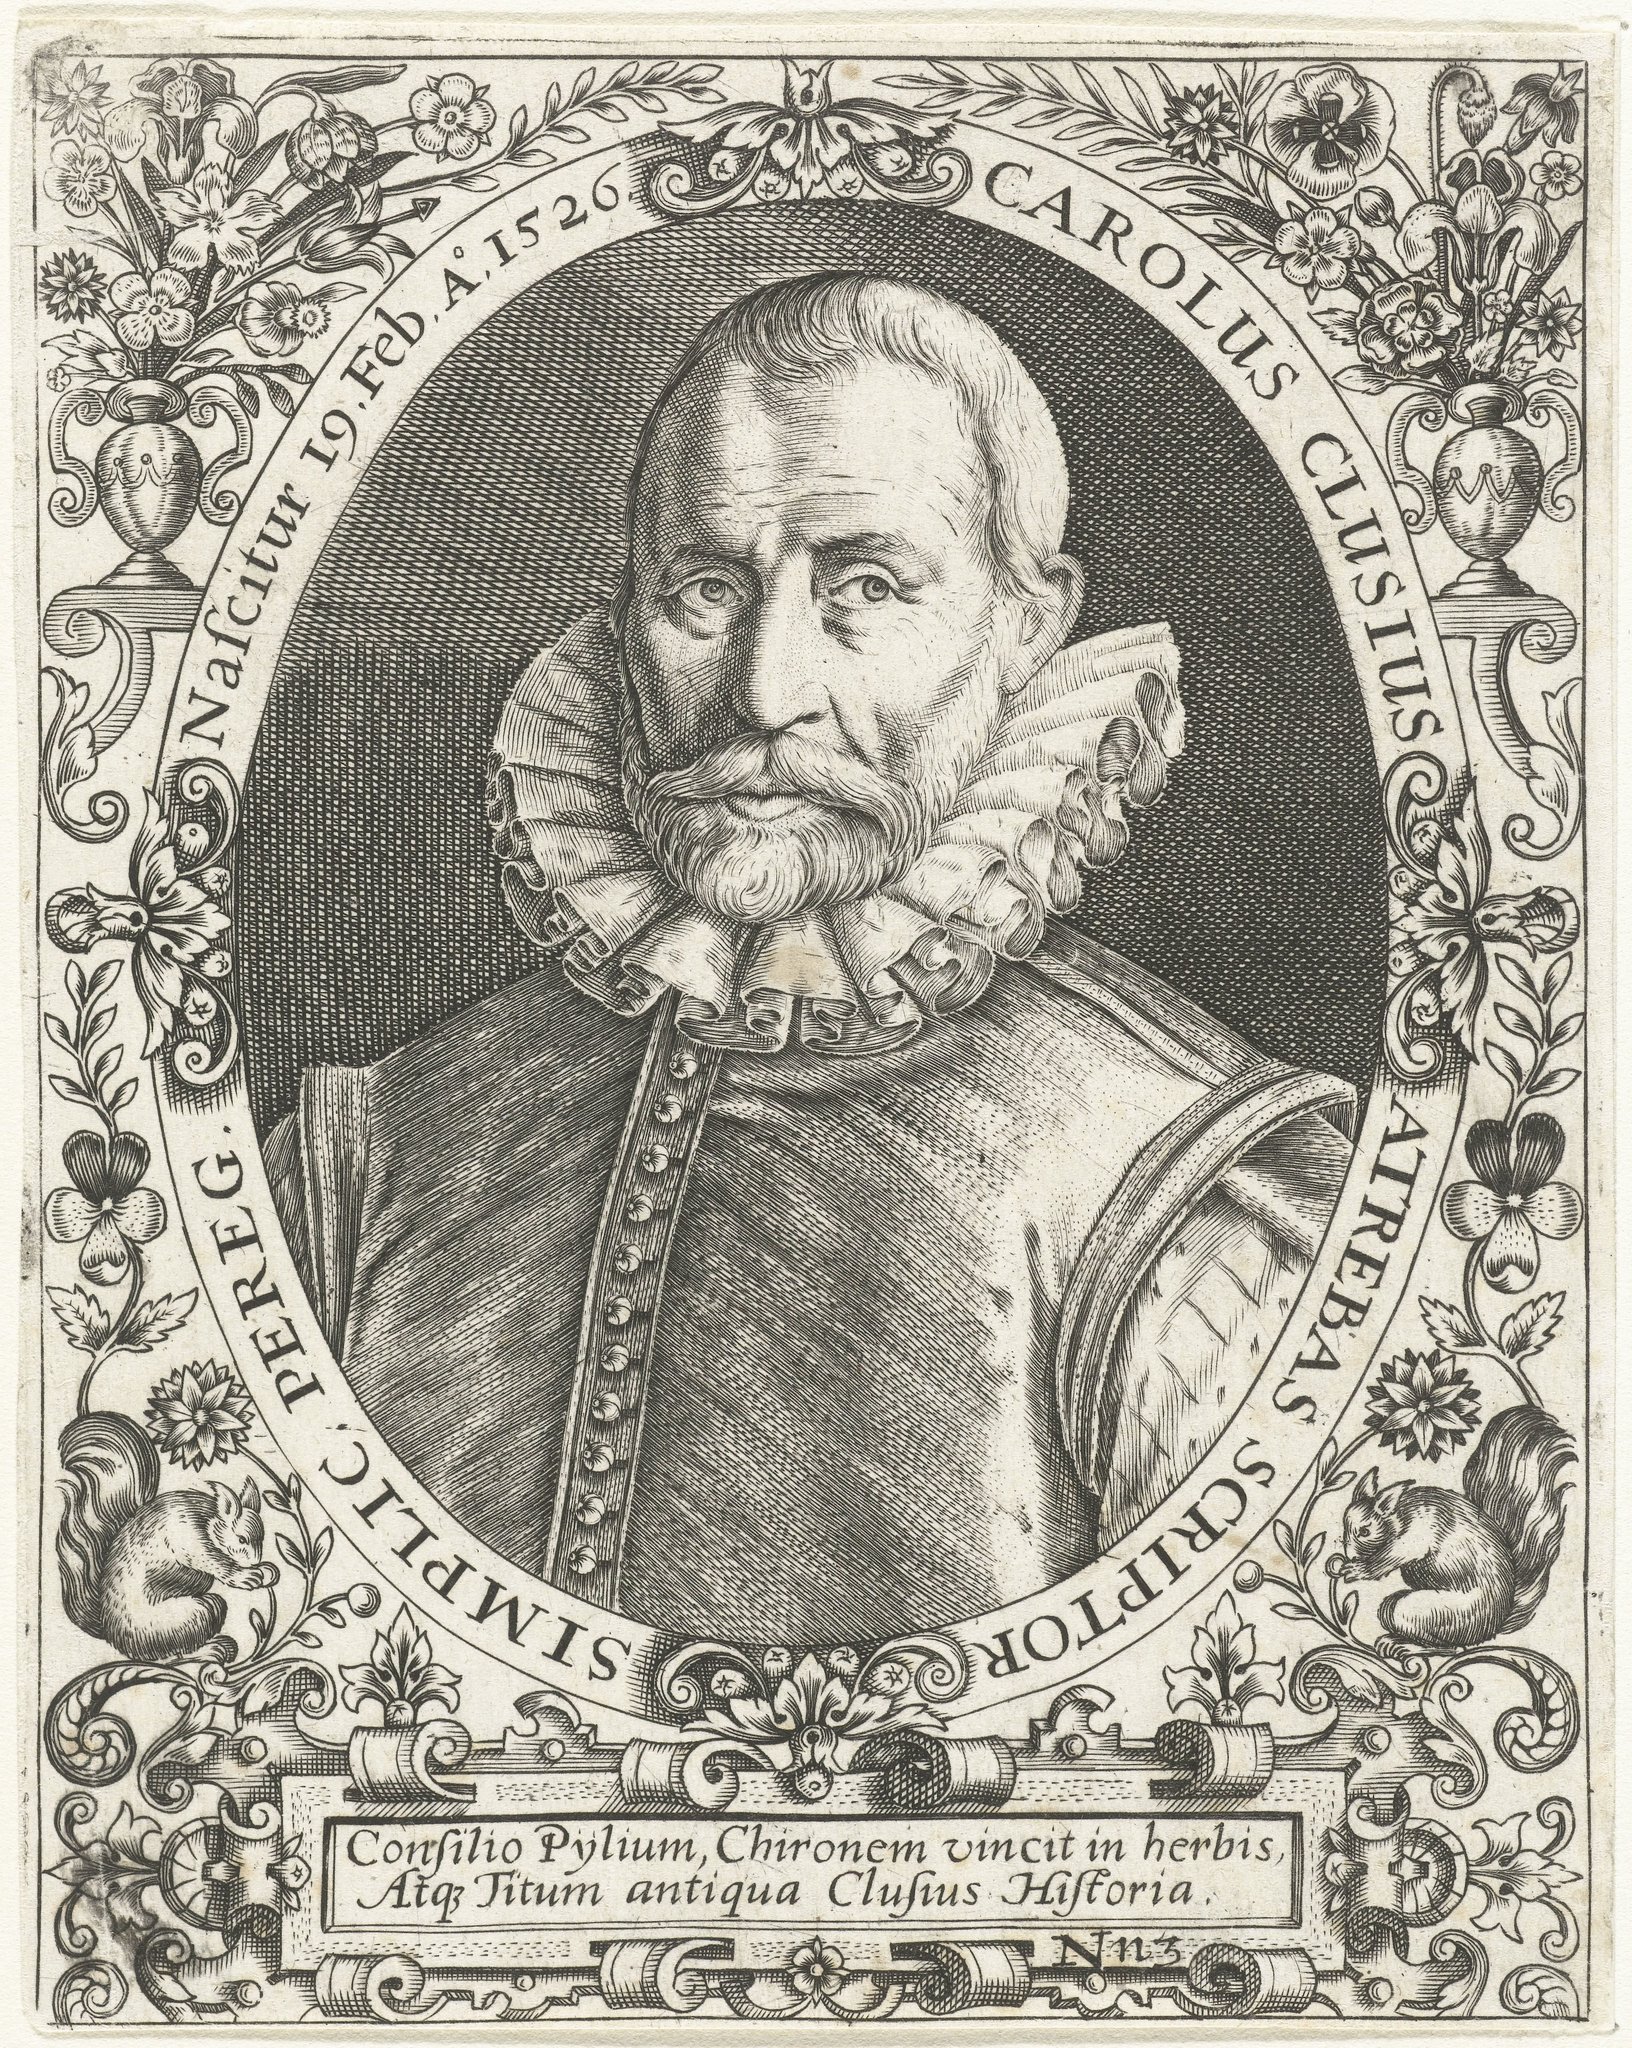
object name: print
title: Portret van Carolus Clusius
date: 1669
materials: paper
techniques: engraving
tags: leiden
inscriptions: collector's mark: Lugt 2228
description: Gemaakt voor: J.J. Boissard, Icones virorum illustrium doctrina &c eruditione praestanti um contines. Frankfurt am Main: de Bry, 1597-1599. Opnieuw gebruikt in: J.J.Boissard, Bibliotheca chalcographica, hoc est Virtute et eruditione clarorum Virorum Imagines. Heidelberg: Clemens Ammon, 1669. Dl. 1-5 (te herkennen aan de toegevoegde signatuur in de rechter onderhoek: 2N3).